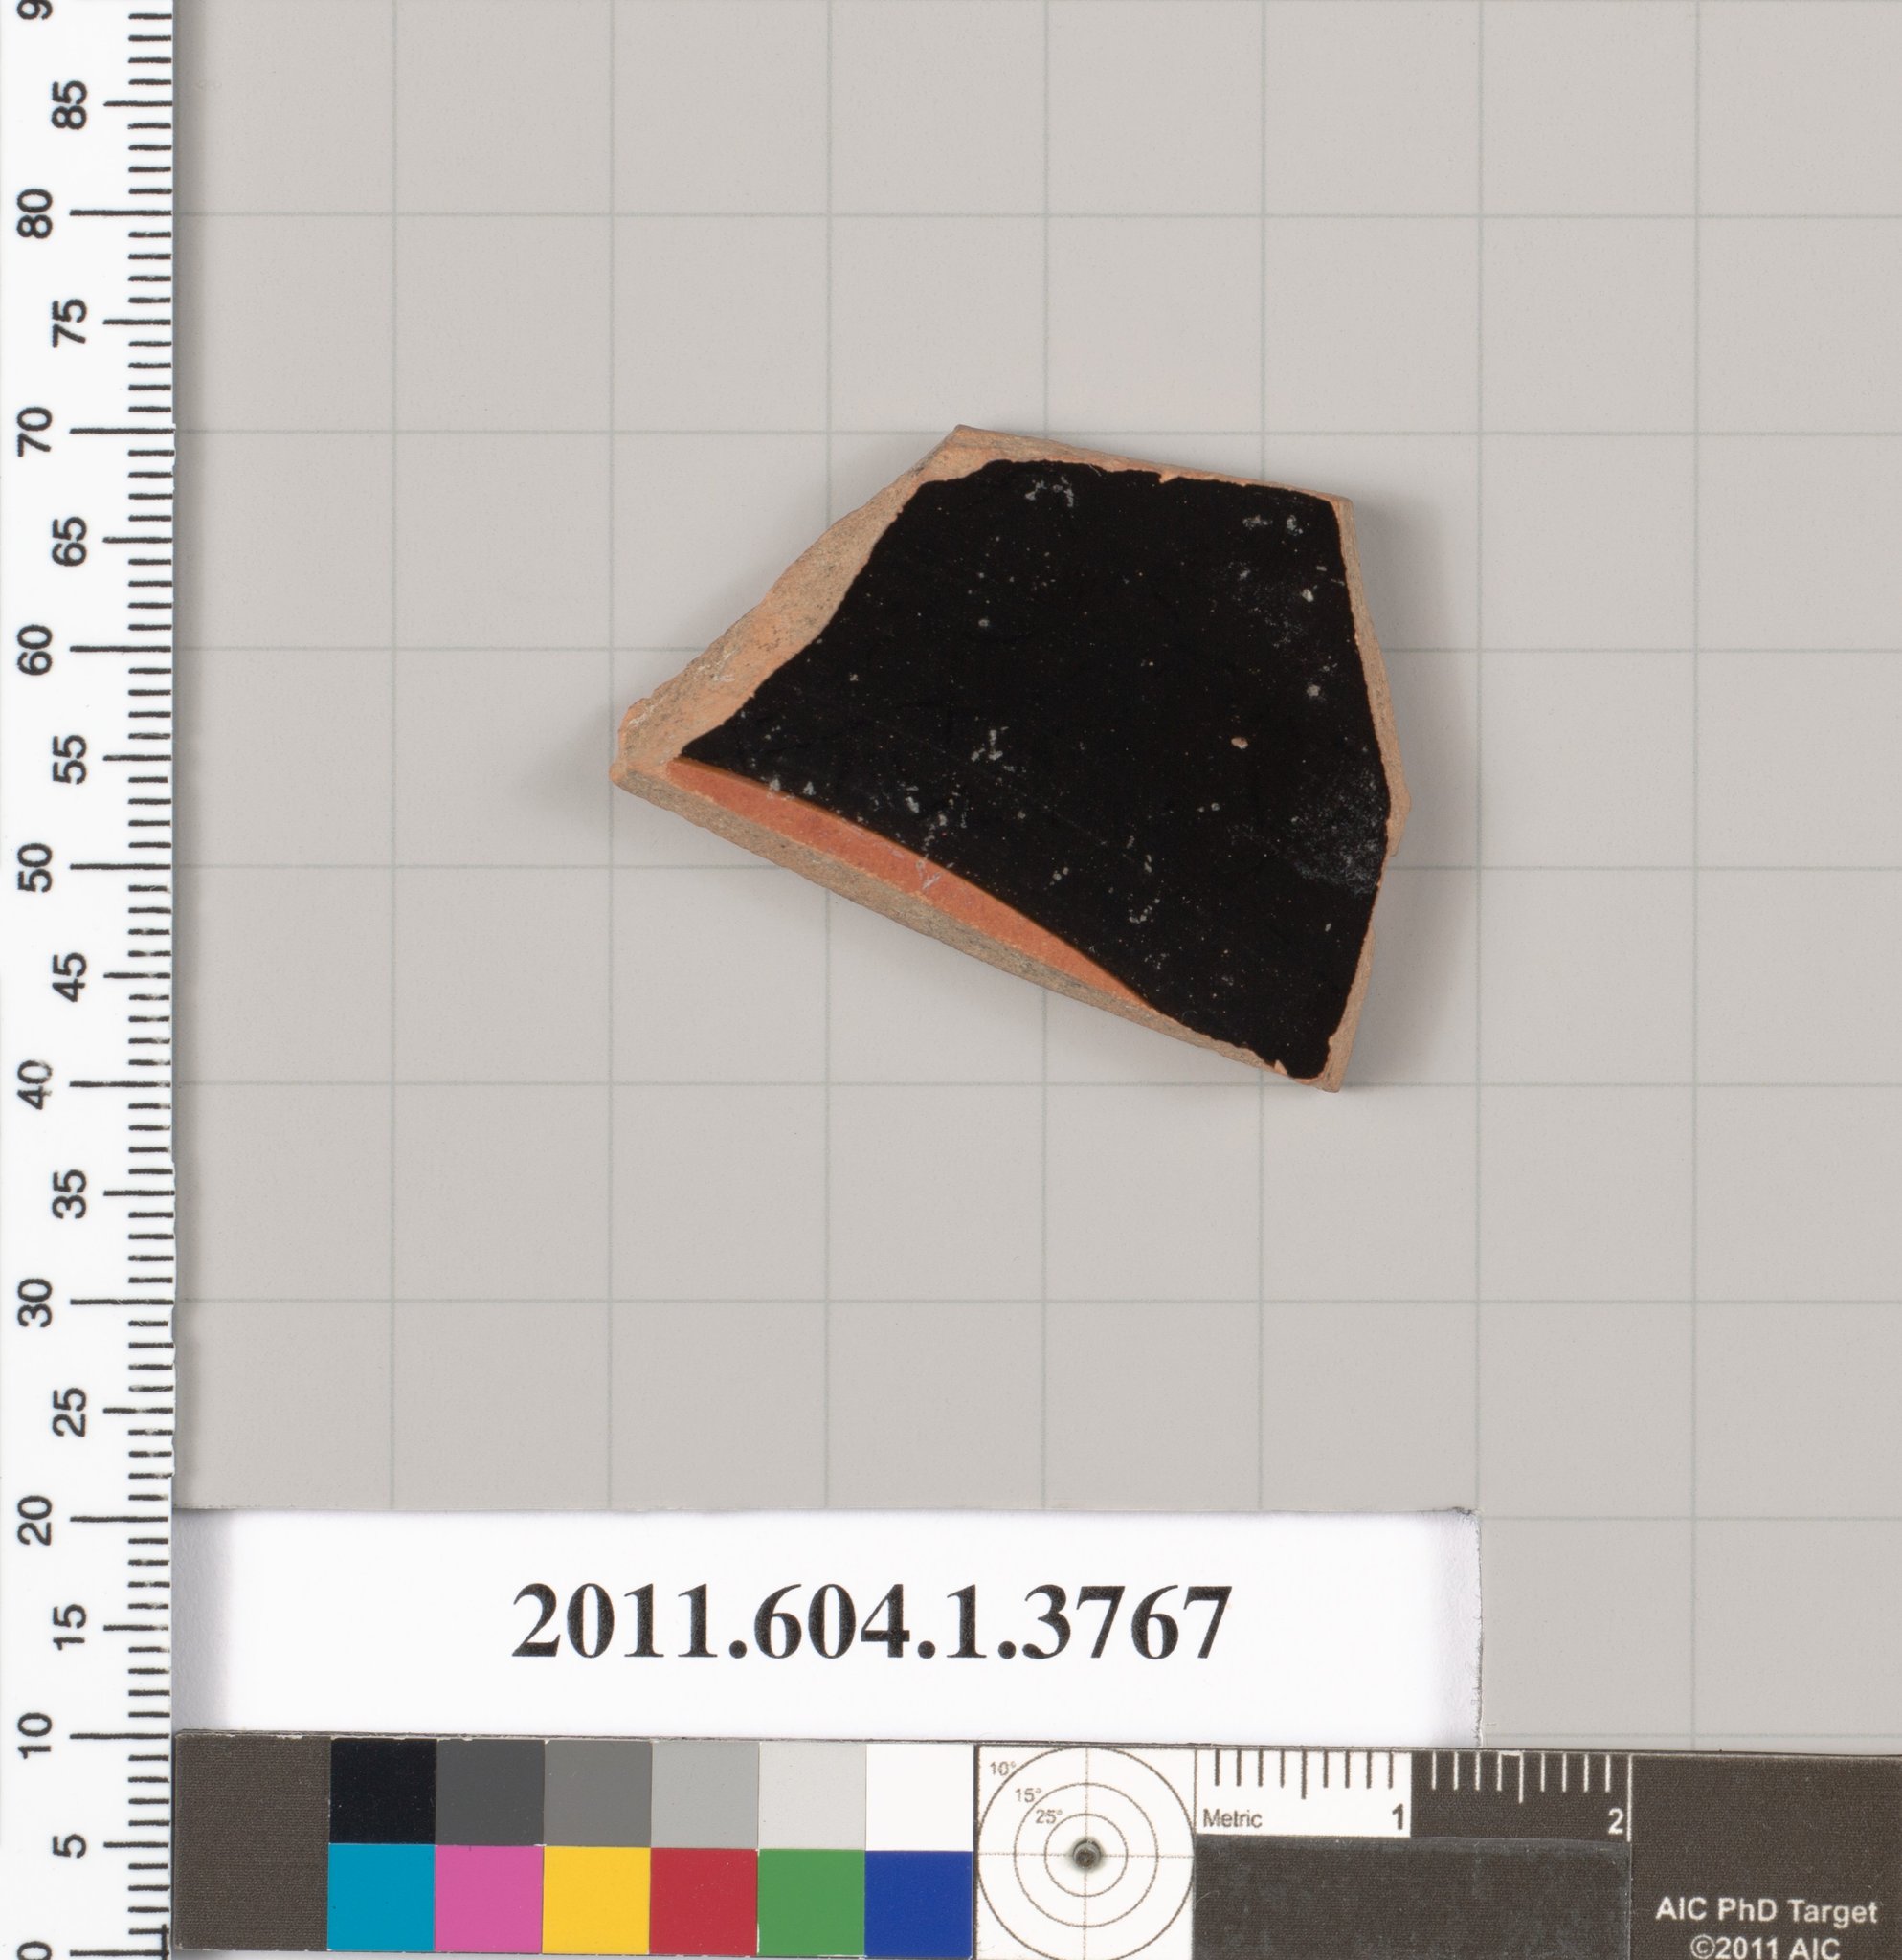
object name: kylix fragment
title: Terracotta fragment of a kylix (drinking cup)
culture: greek, attic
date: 475-451 BCE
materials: terracotta